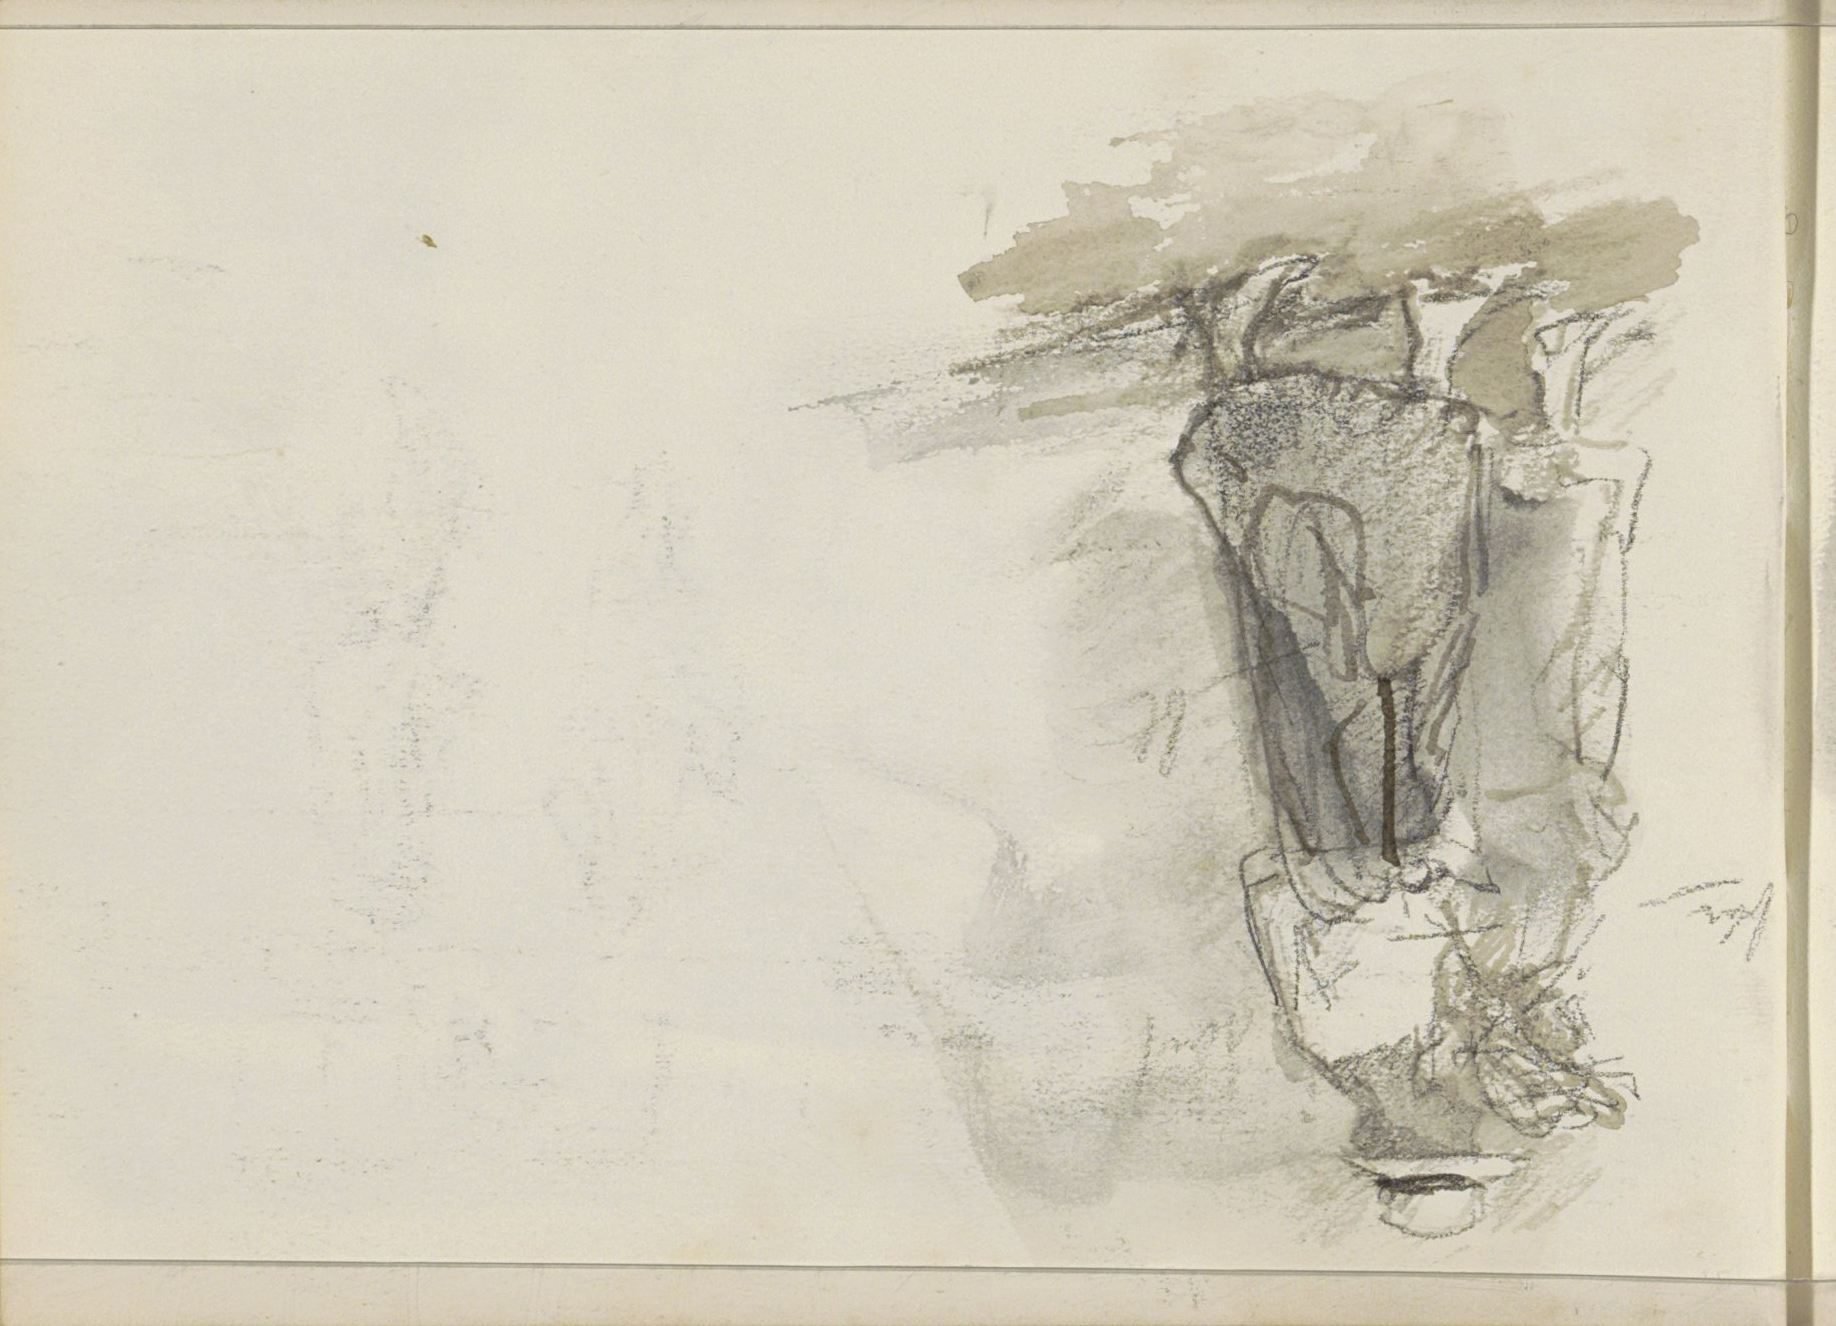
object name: sketchbook leaf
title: Twee vrouwen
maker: johan antonie de jonge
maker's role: draughtsman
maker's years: 1864-1927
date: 1920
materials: chalk, paper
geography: south holland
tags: adult woman (+ two persons)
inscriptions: kleurnotitie, handgeschreven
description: Twee vrouwen. Blad 16 verso uit een schetsboek met 21 bladen.